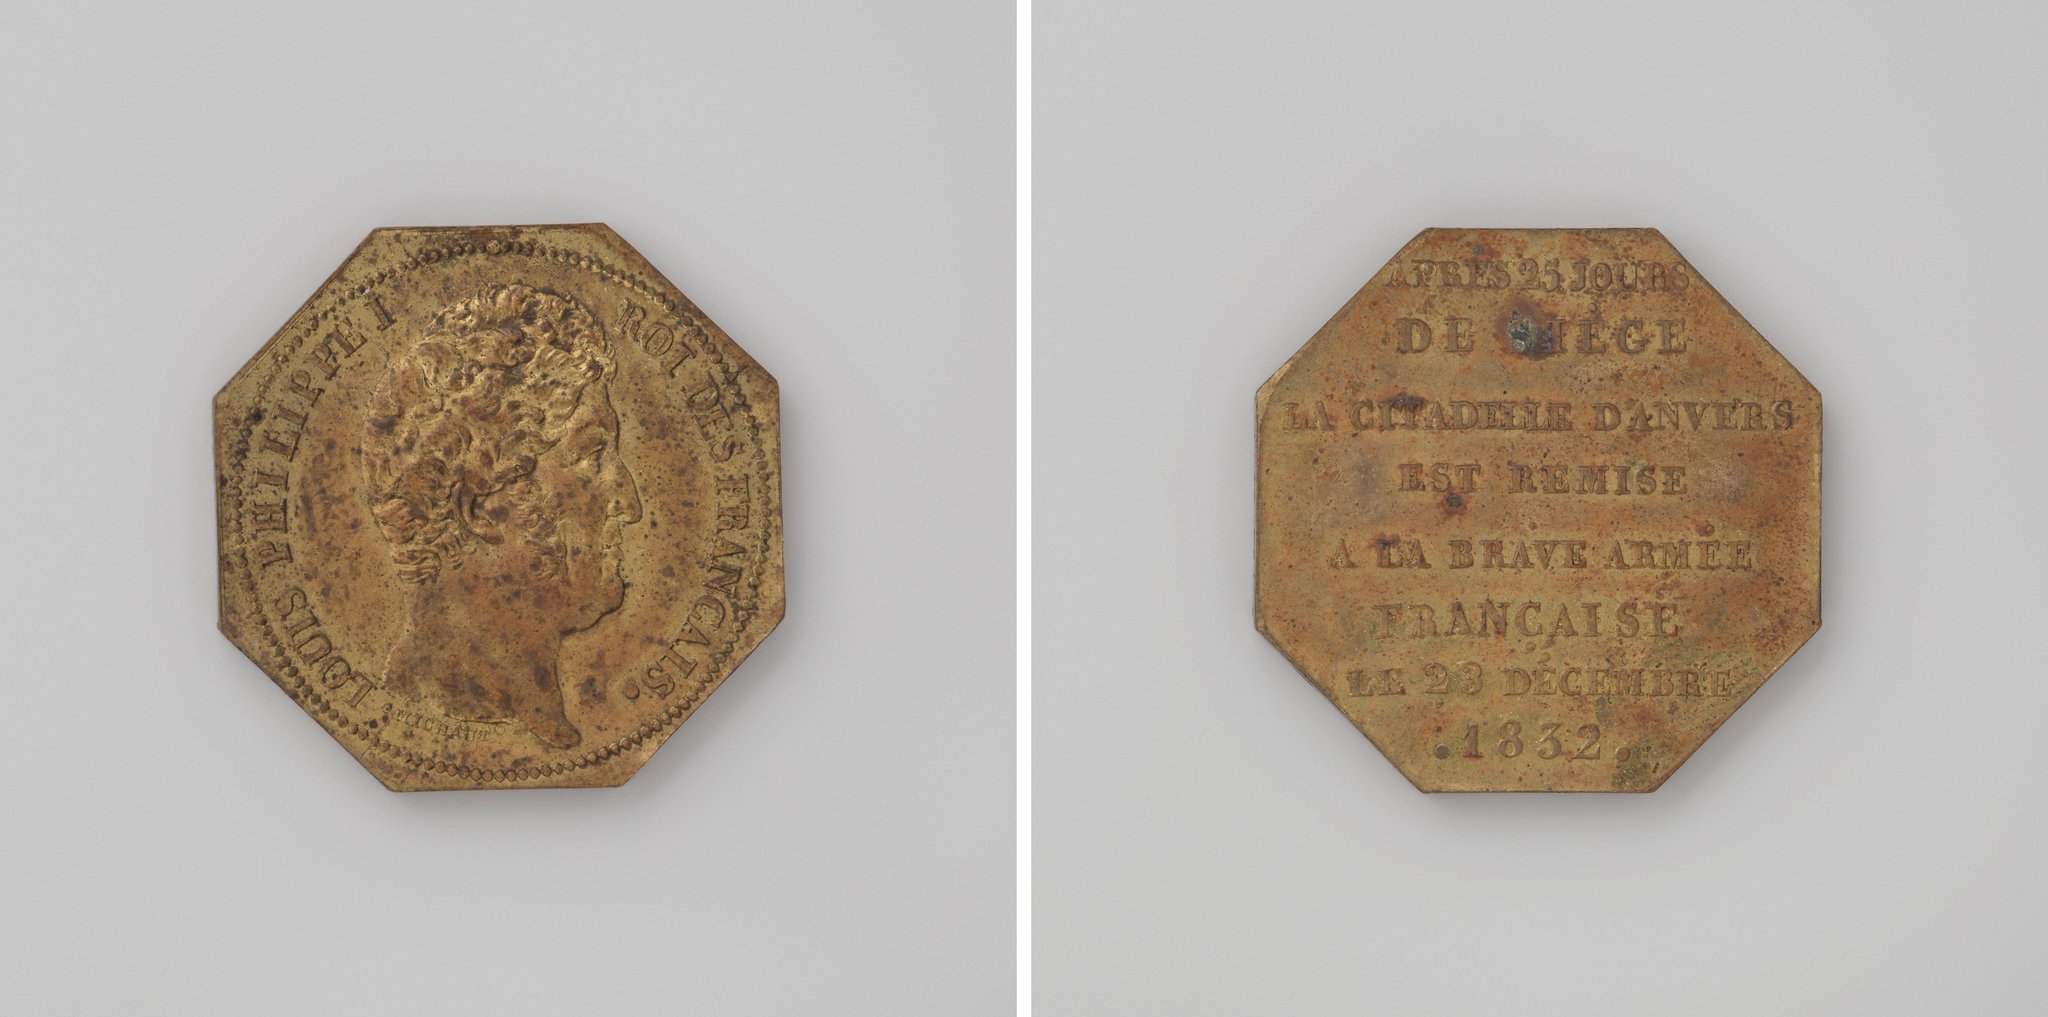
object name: history medal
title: Verovering van de citadel van Antwerpen, ter ere van Lodewijk Filips, koning der Fransen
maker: auguste francois michaut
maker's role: sculptor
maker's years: 1786-1879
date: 1832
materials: copper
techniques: striking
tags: lodewijk filips i (koning van frankrijk)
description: Achthoekige koperen penning. Voorzijde: borststuk man binnen omschrift. Keerzijde: opschrift.